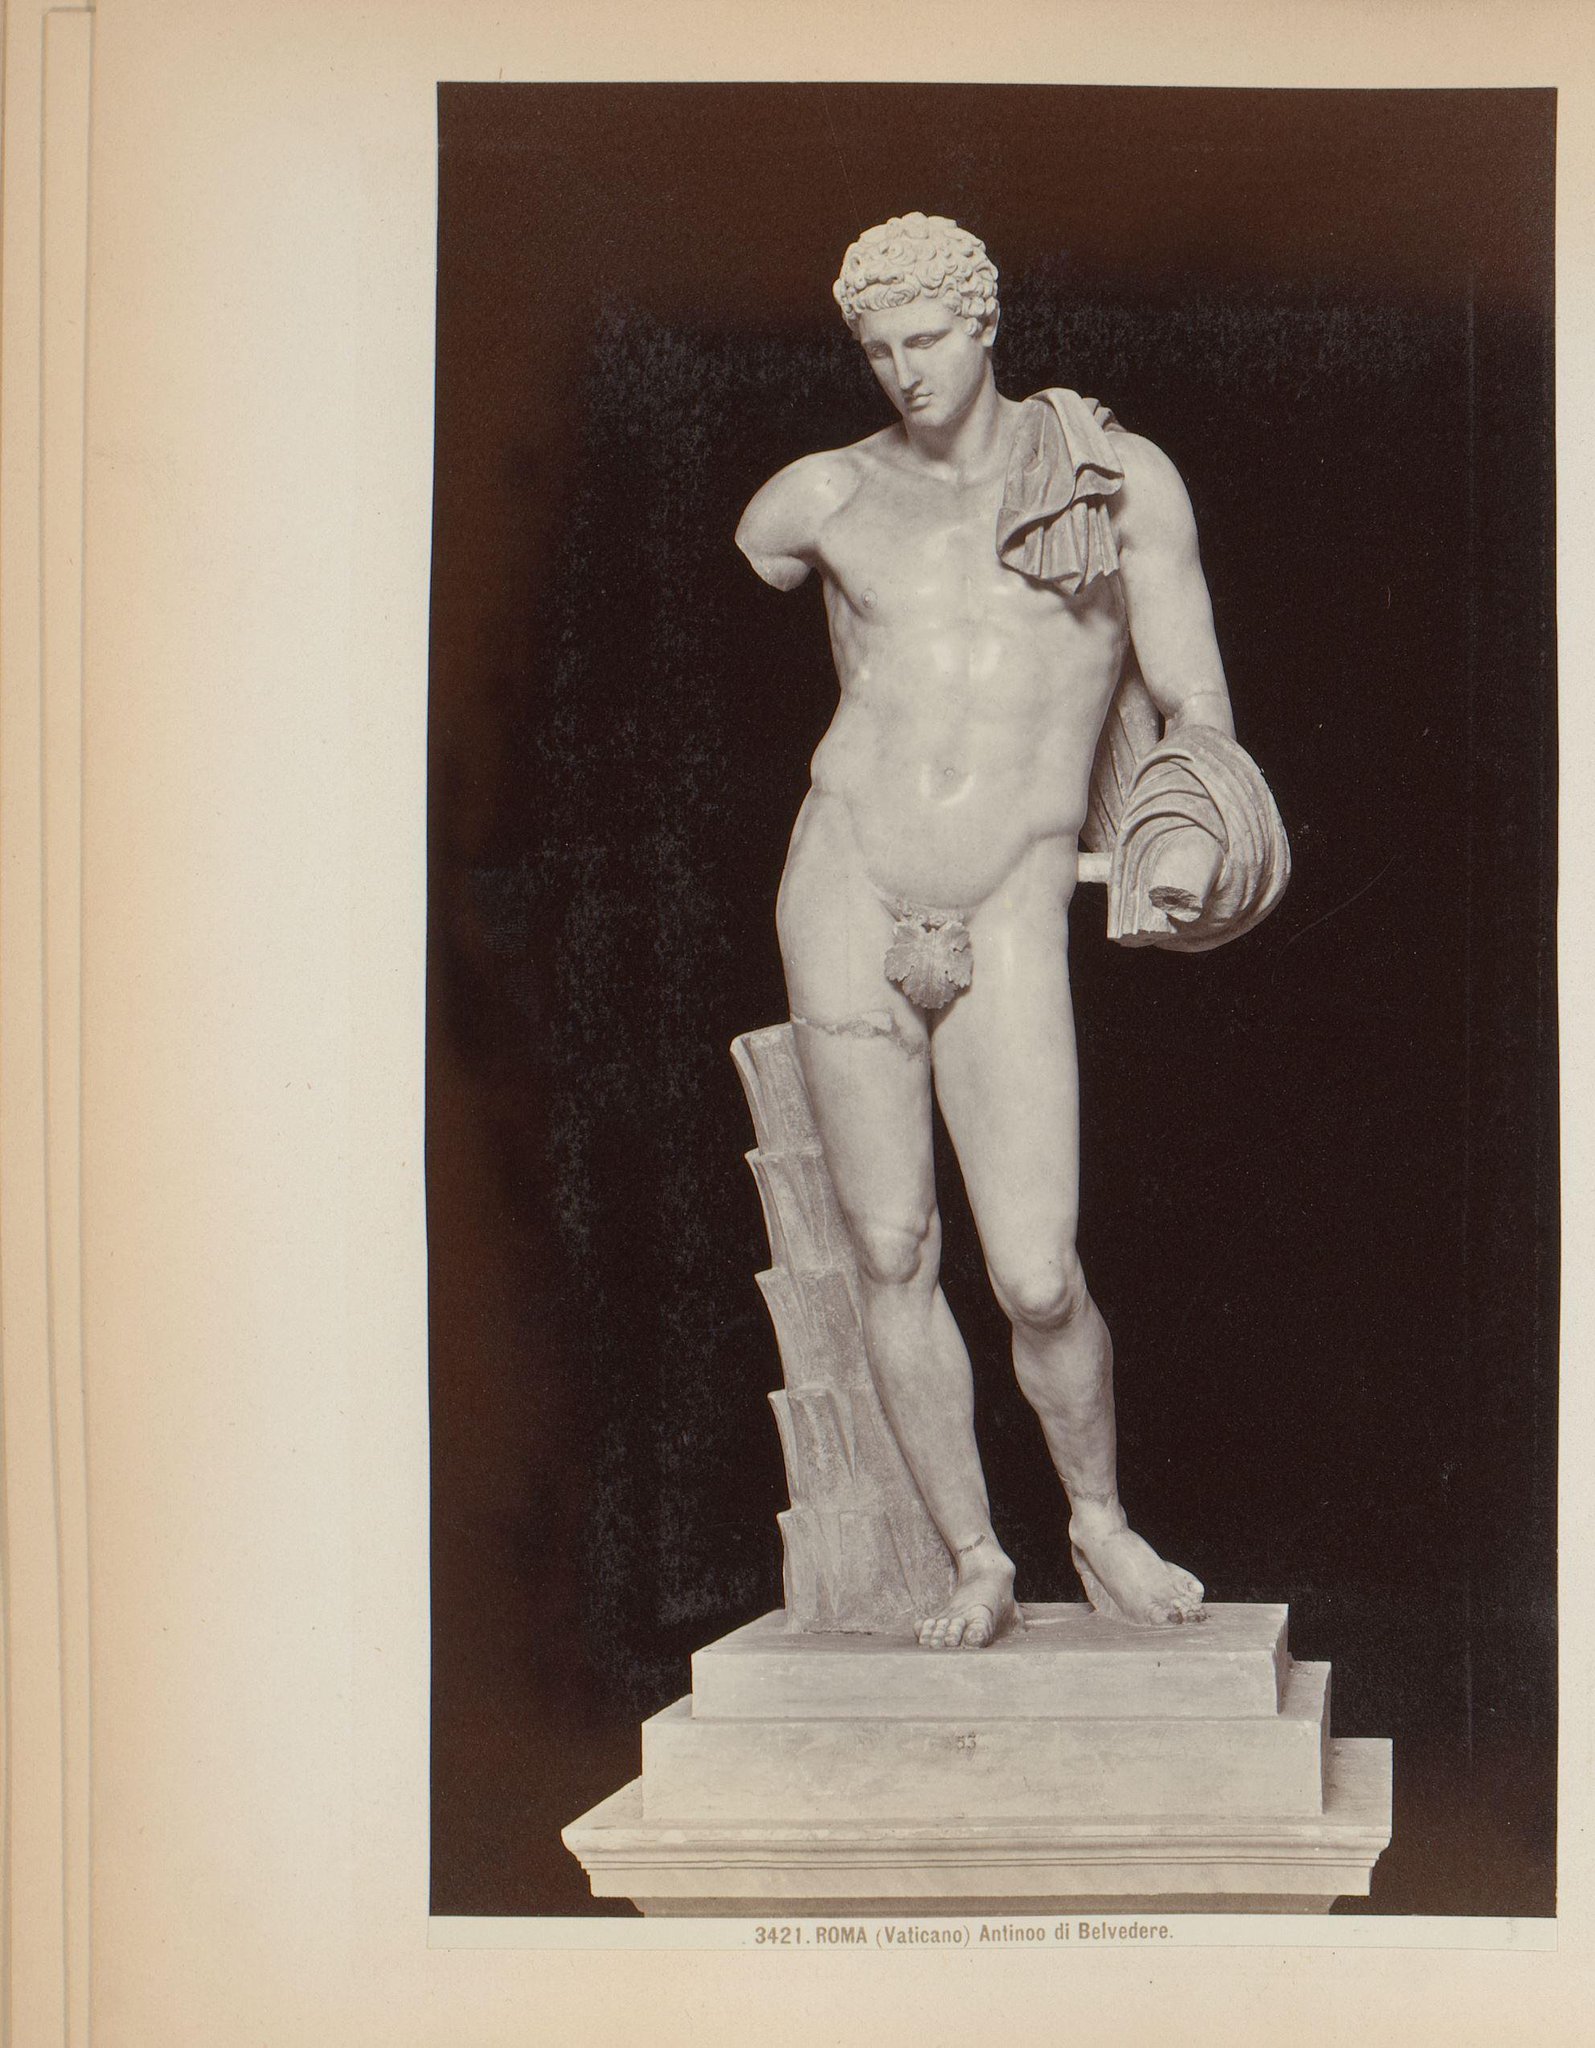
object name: album leaf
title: Sculptuur van Hermes van Belvedere in de Vaticaanse Musea te Rome, Italië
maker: giacomo brogi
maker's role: fotograaf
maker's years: 1822-1881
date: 1870-1881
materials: paper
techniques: albumen print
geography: rome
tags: piece of sculpture, reproduction of a piece of sculpture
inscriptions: number: ‘3421.’